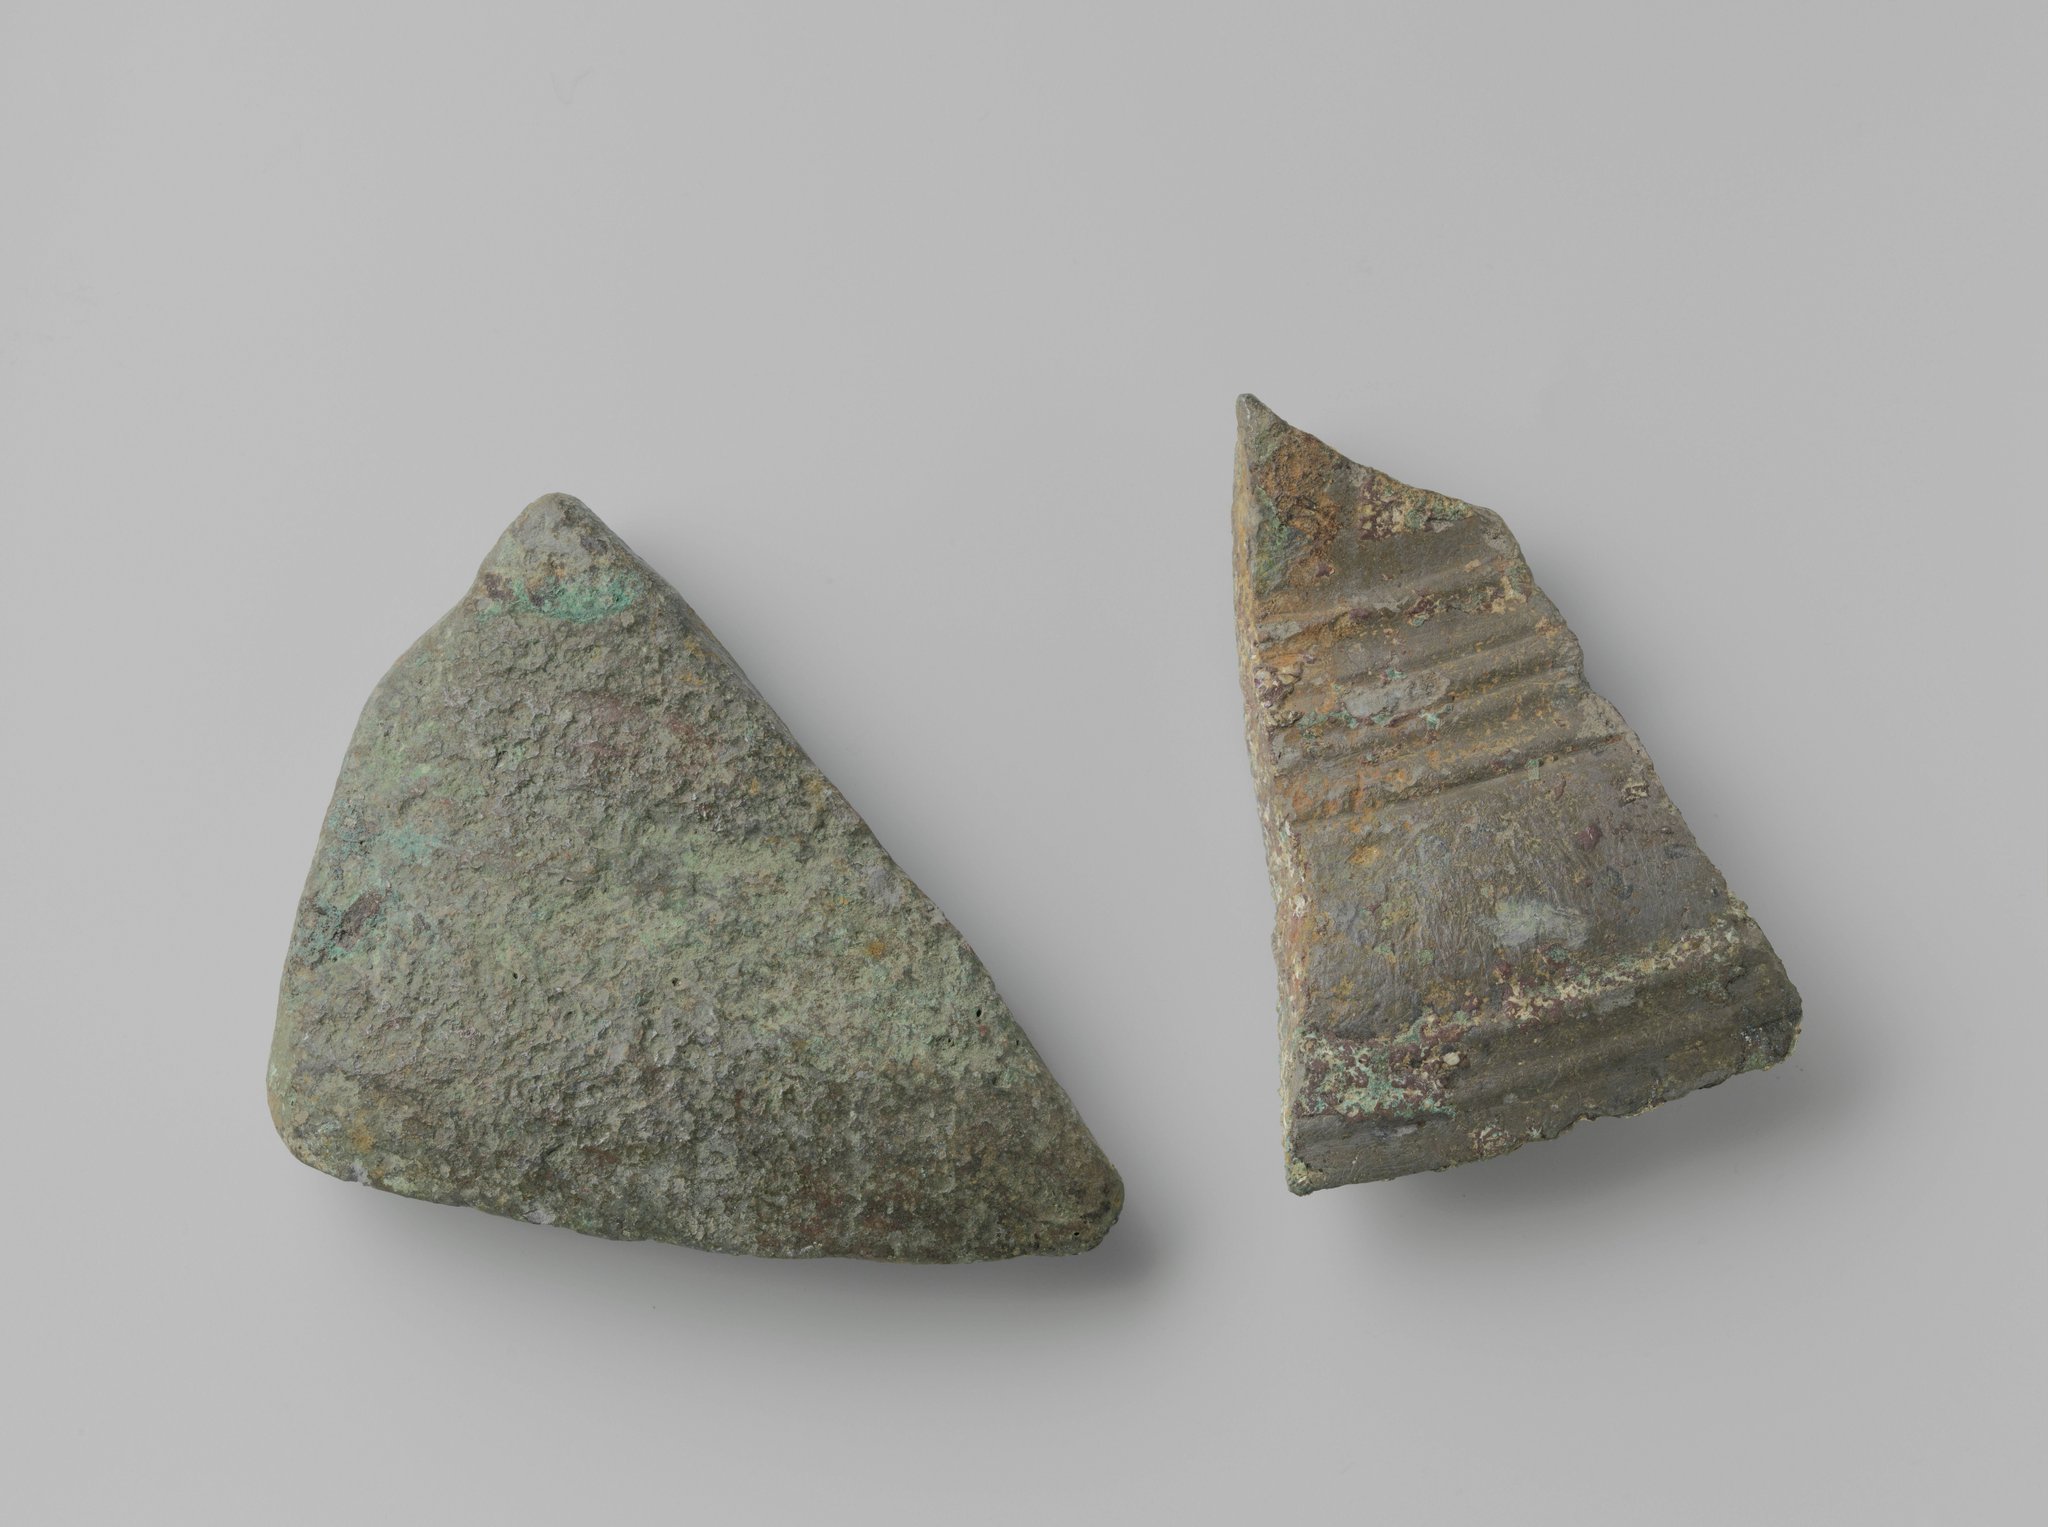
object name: percussion instrument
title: Fragments of a ship bell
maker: Anonymous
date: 1700-1743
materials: copper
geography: netherlands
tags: verenigde oostindische compagnie, hollandia (schip), annet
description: Acoustic, bell (ship's); fragment of rim, eroded, concentric band moulding, fit to NG 1980-27H2979/1937.